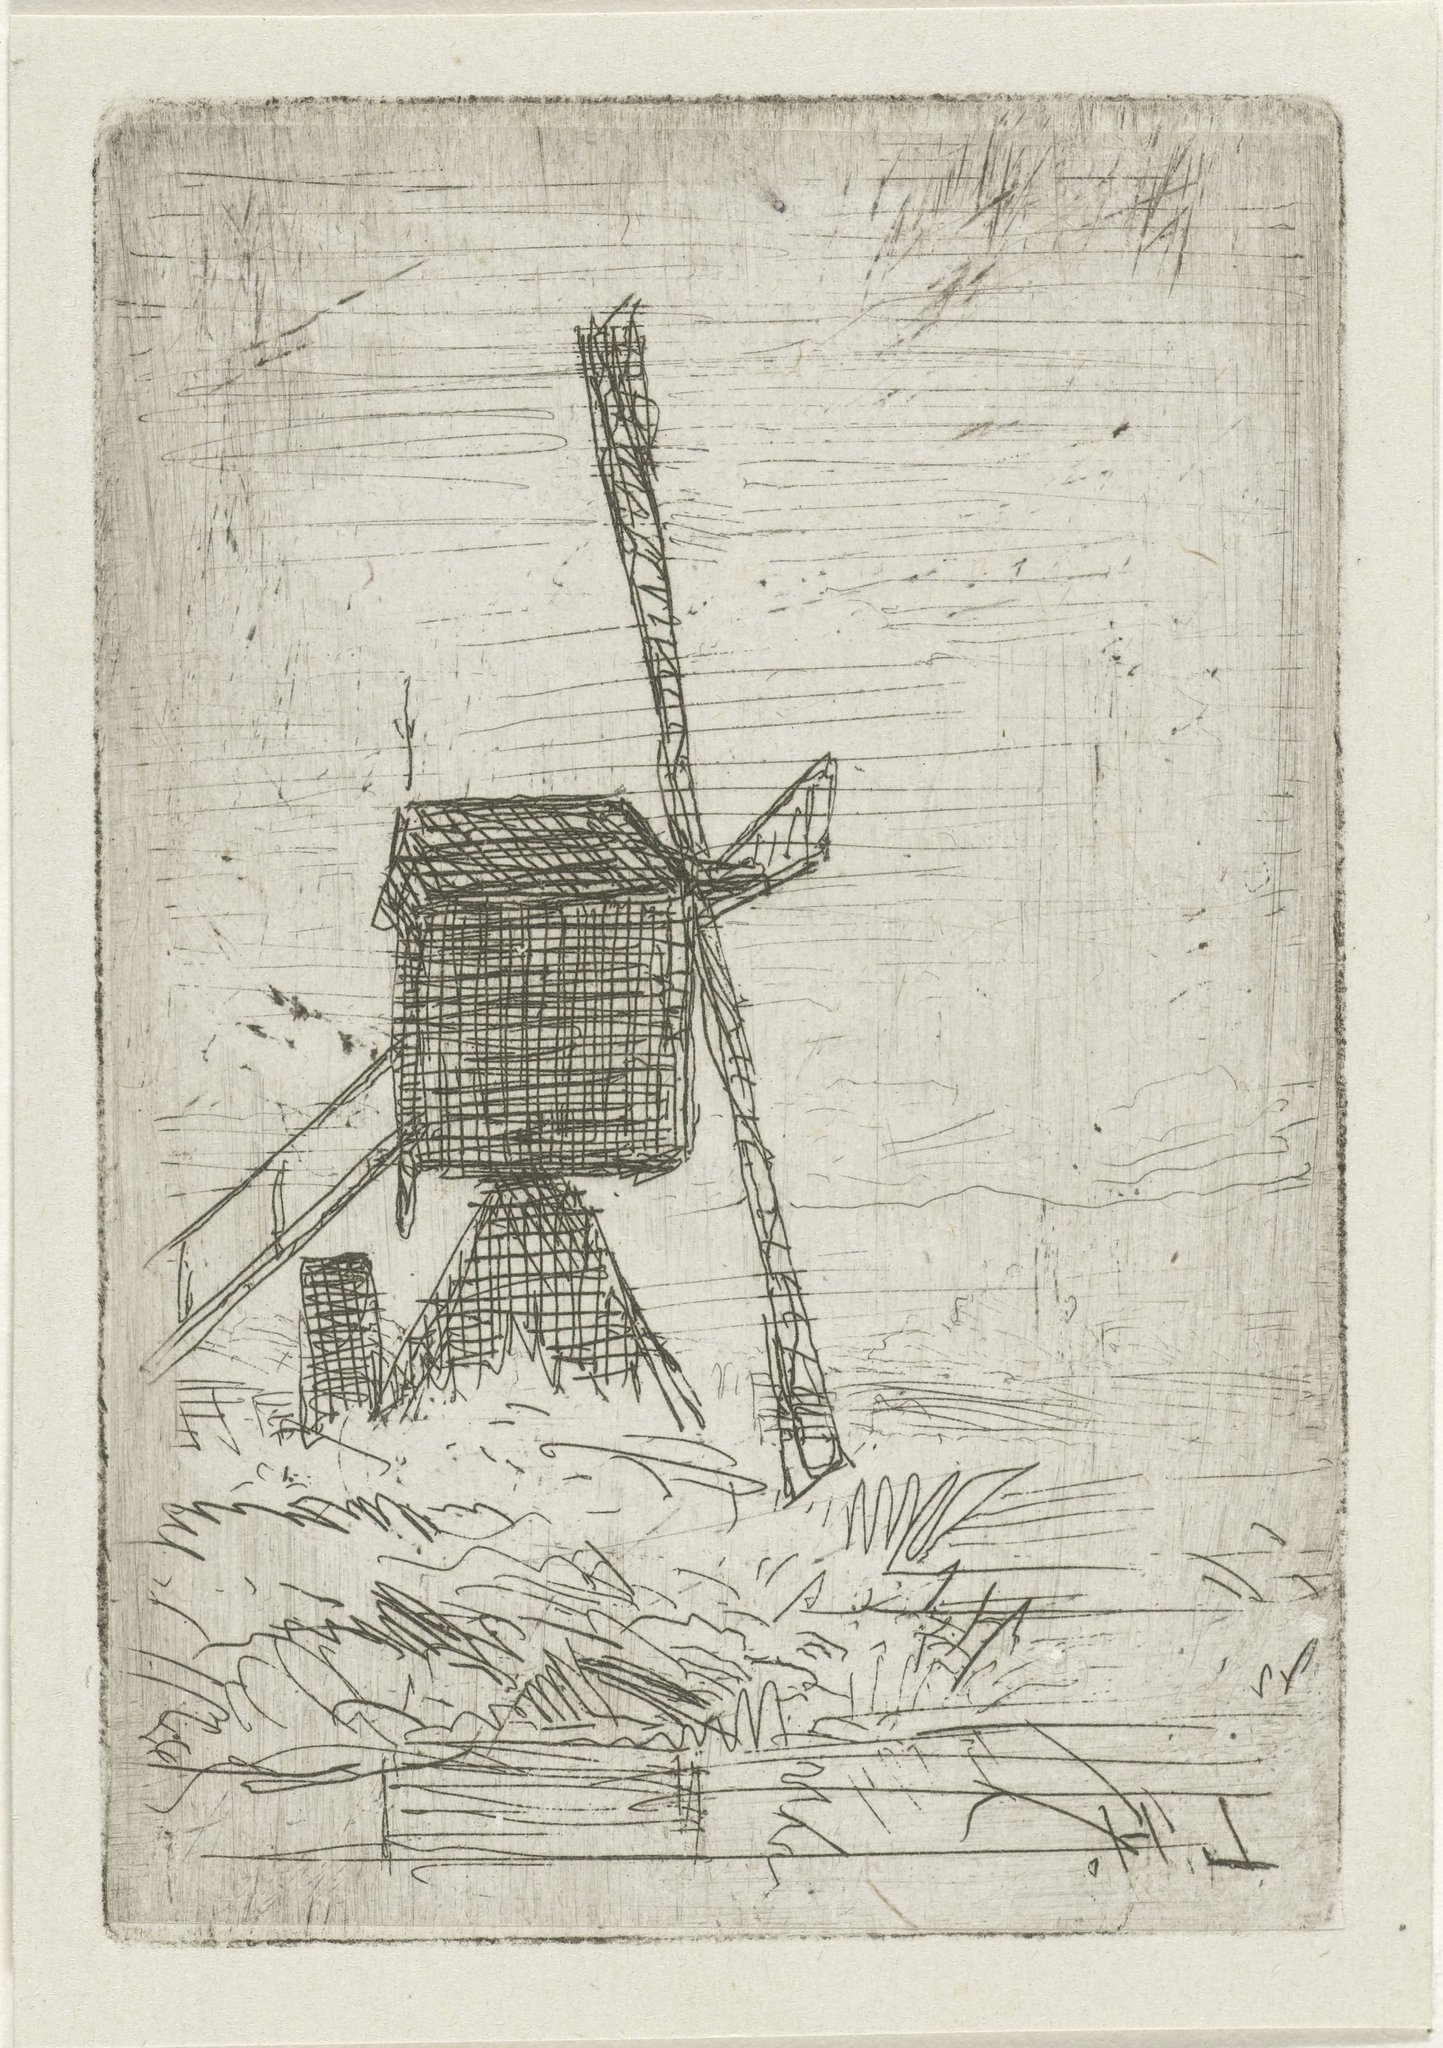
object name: print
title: Molen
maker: louwrens hanedoes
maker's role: painter, print maker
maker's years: 1822-1905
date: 1837-1905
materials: paper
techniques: etching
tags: windmill in landscape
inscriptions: collector's mark: Lugt 2228